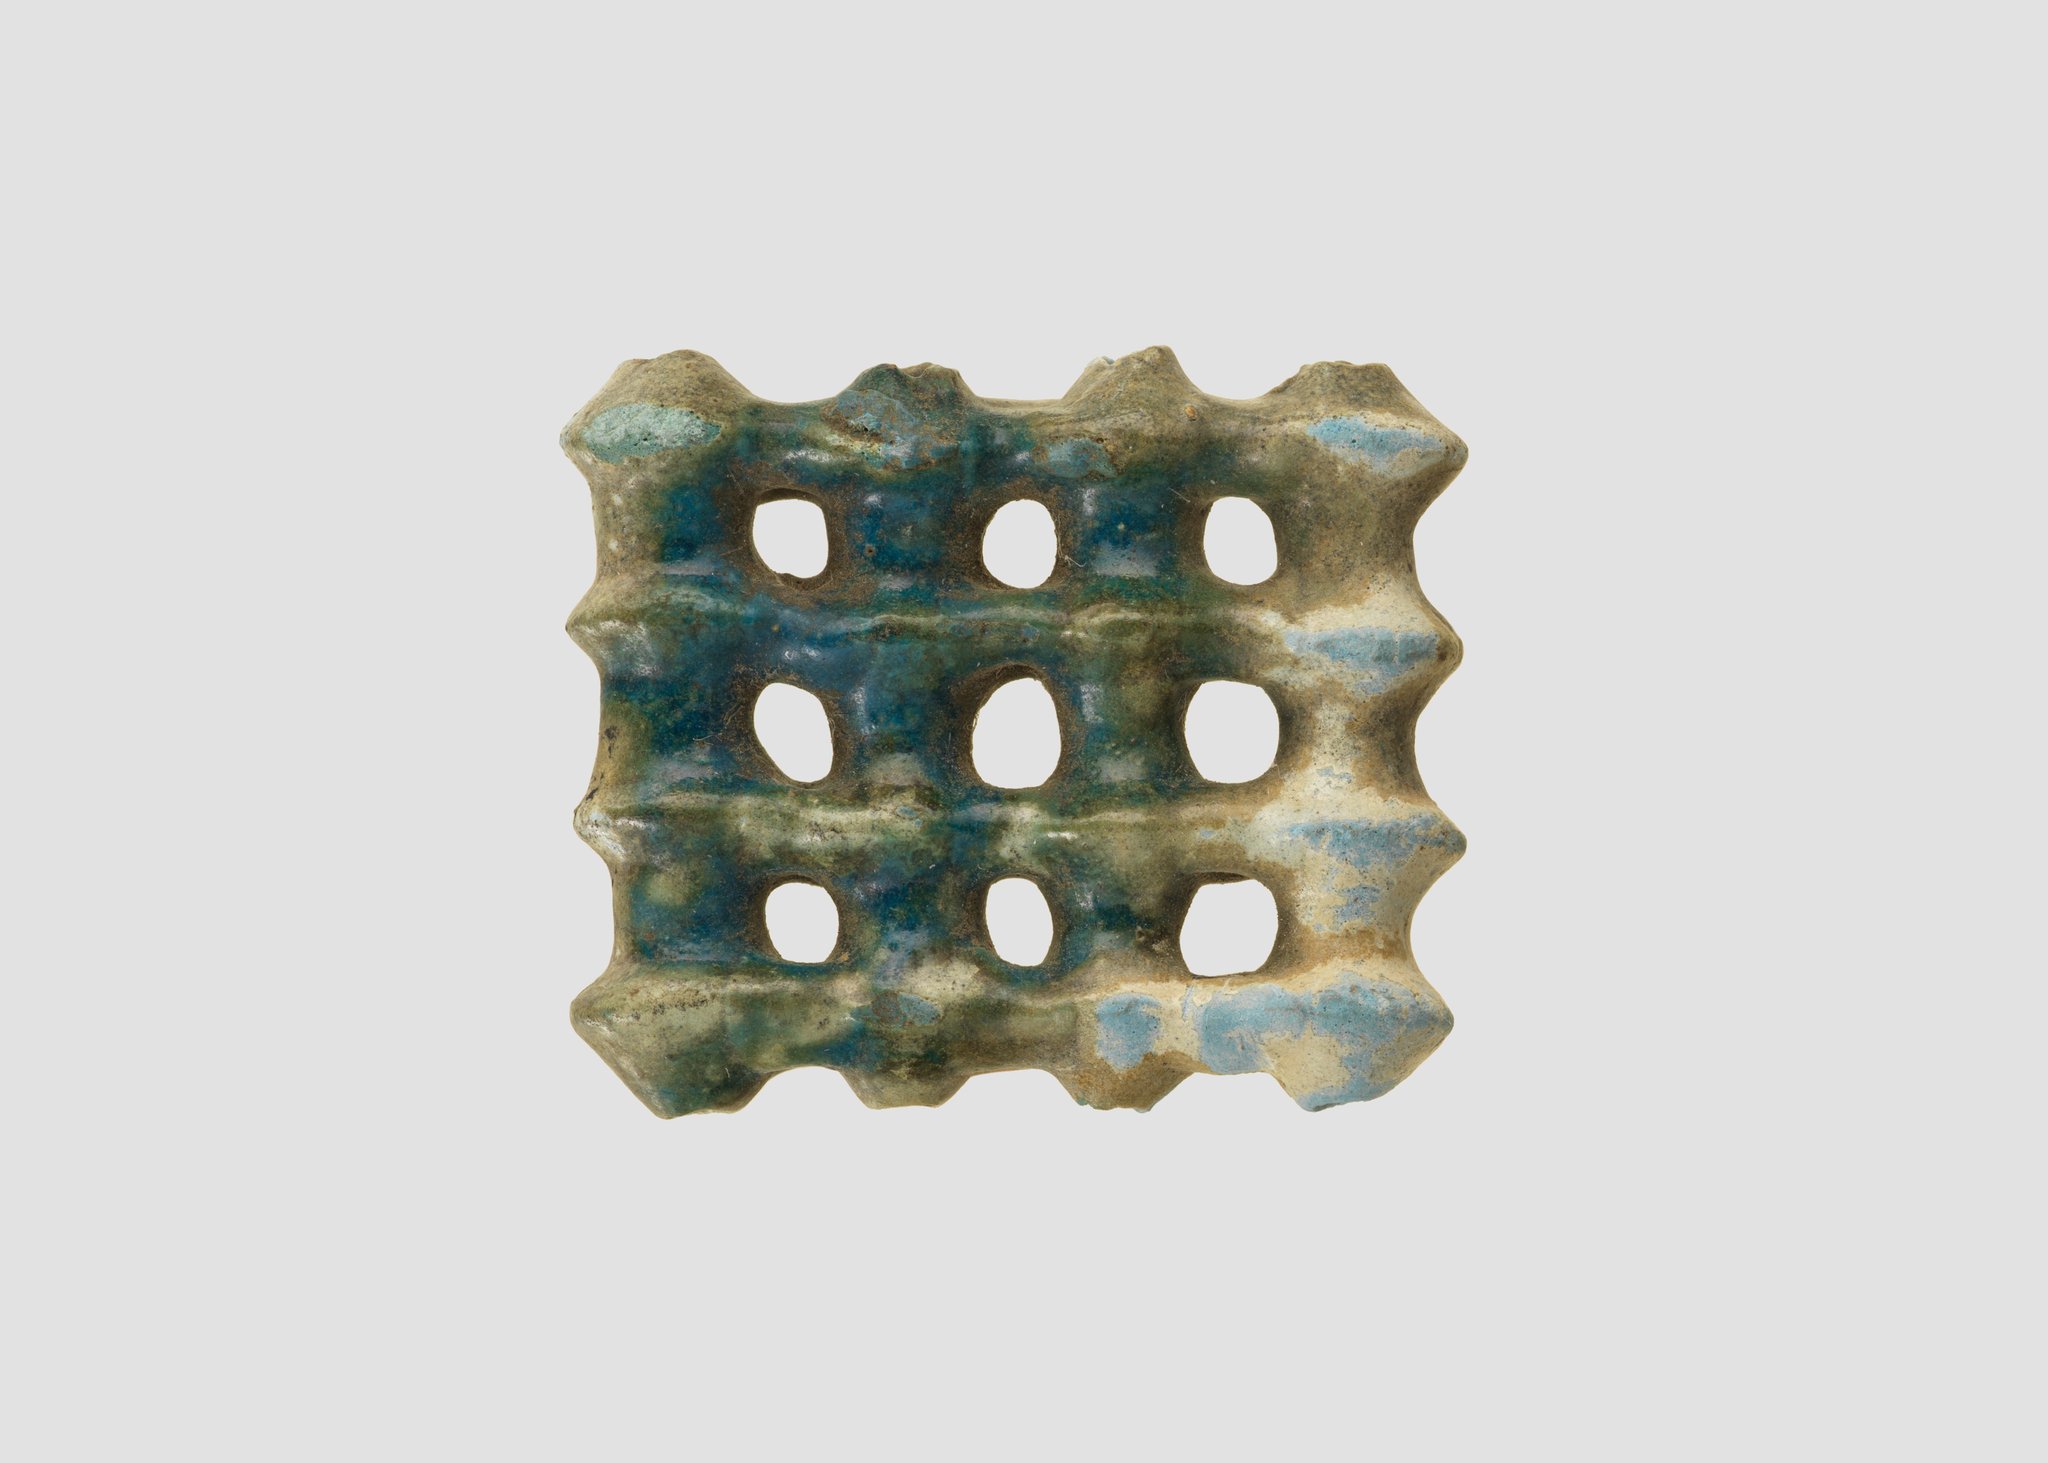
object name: bead spreader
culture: iranian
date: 900-801 BCE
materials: glass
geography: iran